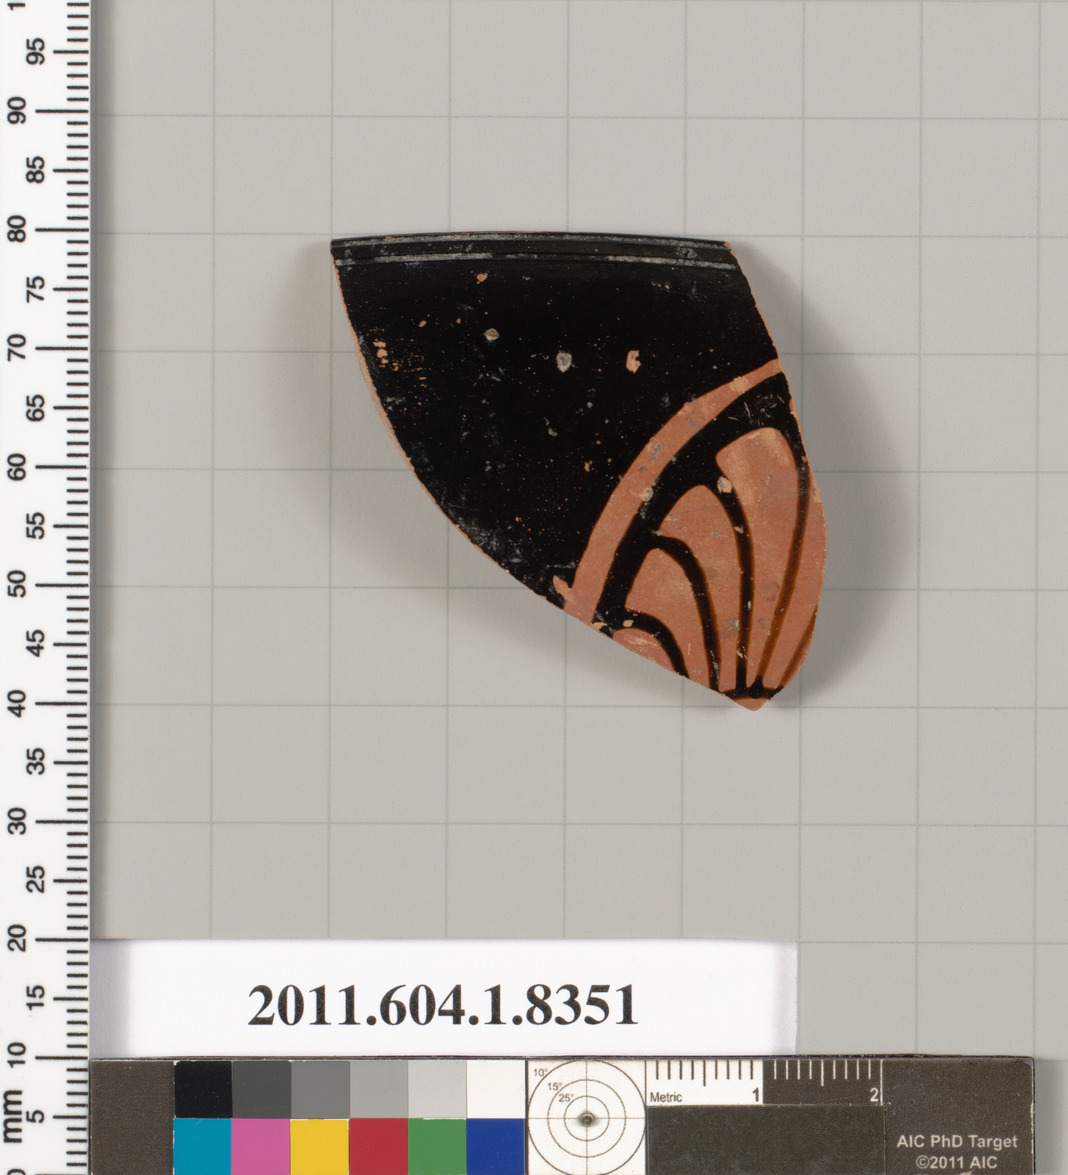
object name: kylix fragment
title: Terracotta rim fragment of a kylix (drinking cup)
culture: greek, attic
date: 425-401 BCE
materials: terracotta